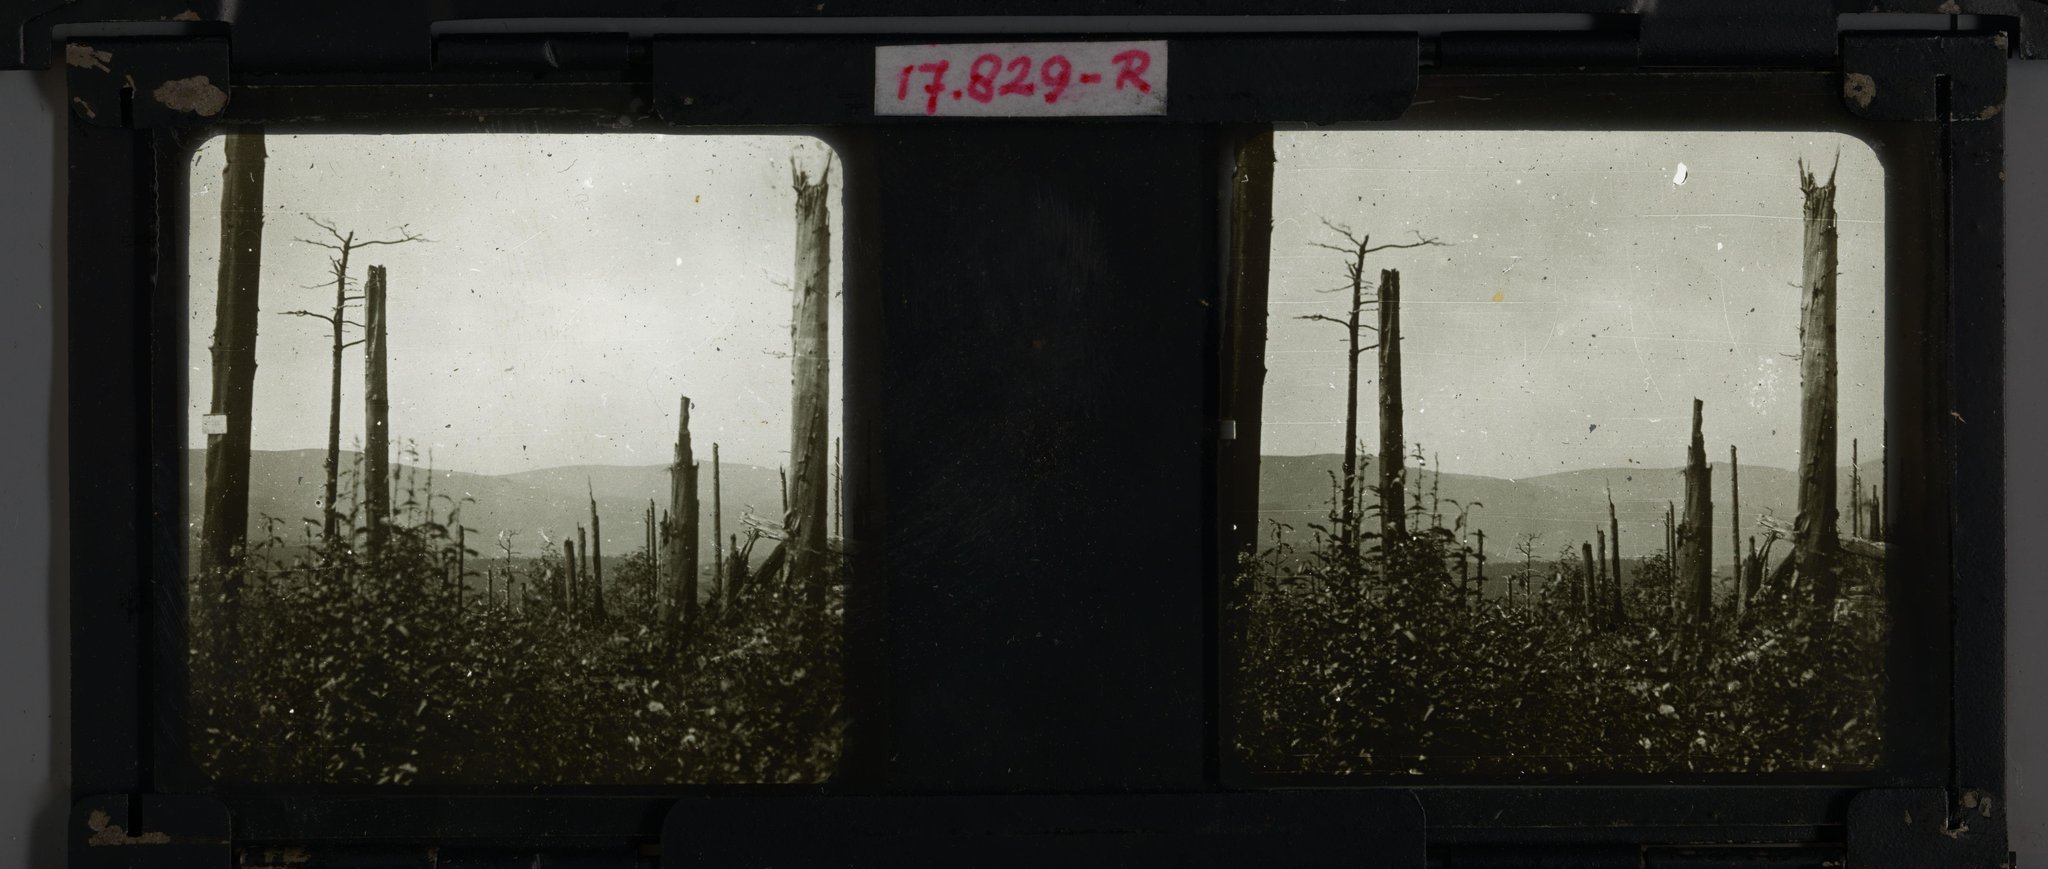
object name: stereoscopic photograph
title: Kale bomen in heuvellandschap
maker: Anonymous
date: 1924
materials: glass, metal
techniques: slide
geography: france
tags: trees, france